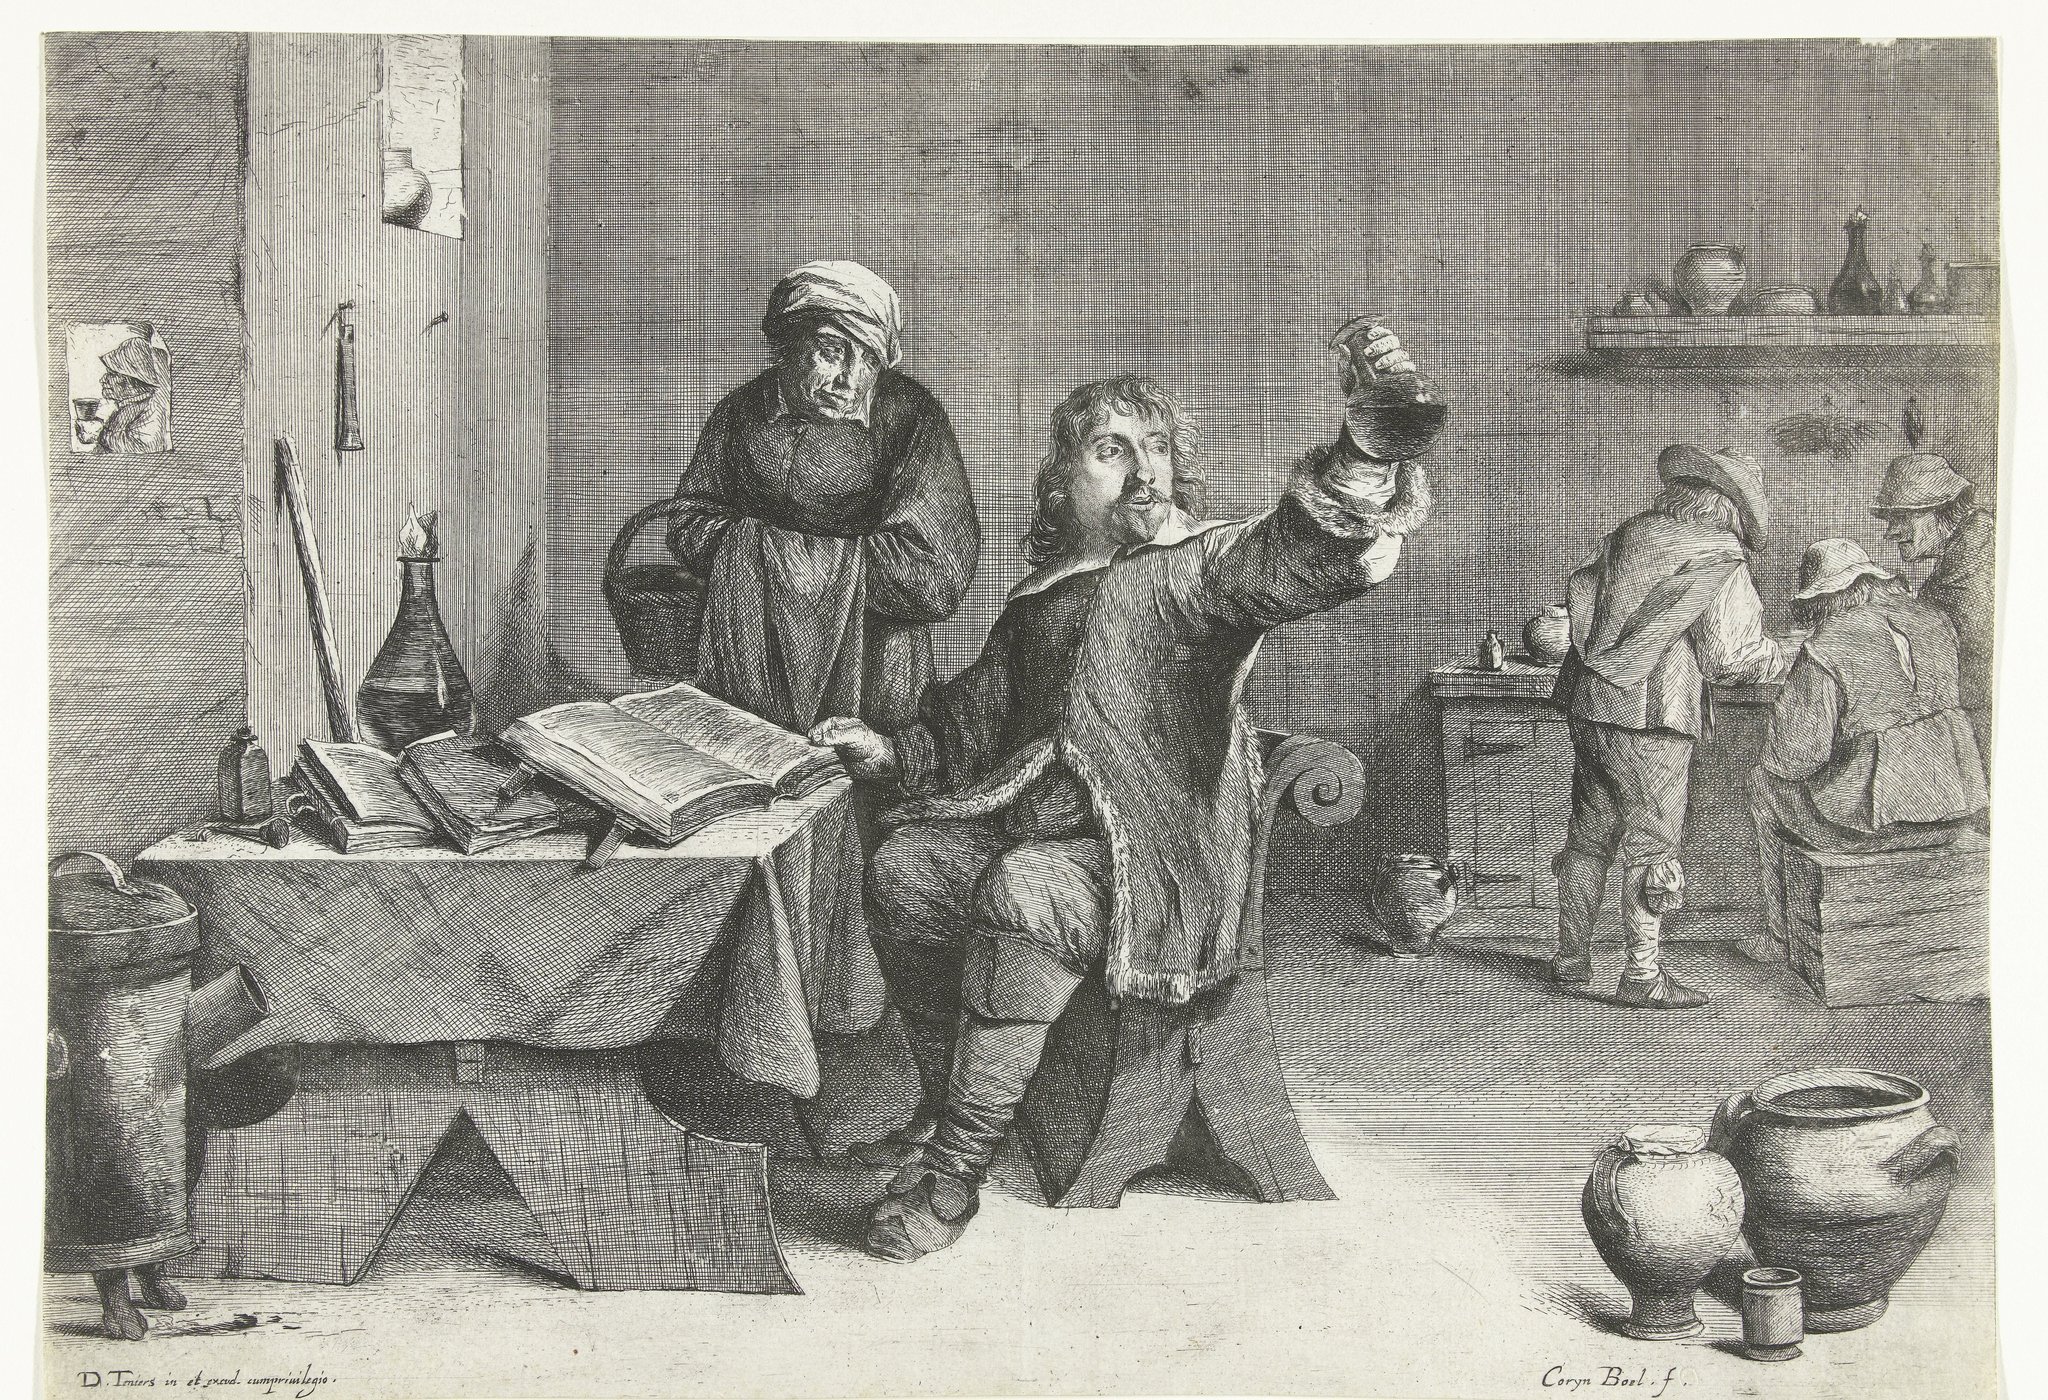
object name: print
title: Bij de dokter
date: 1635-1668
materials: paper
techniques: etching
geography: southern netherlands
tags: examination of urine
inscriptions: check stamp: Lugt 2792a, collector's mark: Lugt 2228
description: Een oude vrouw staat naast een dokter die een vloeistof in een glazen bol in het licht houdt. De dokter zit aan een tafel met boeken. Rechts achter werken drie jongen aan een tafel.